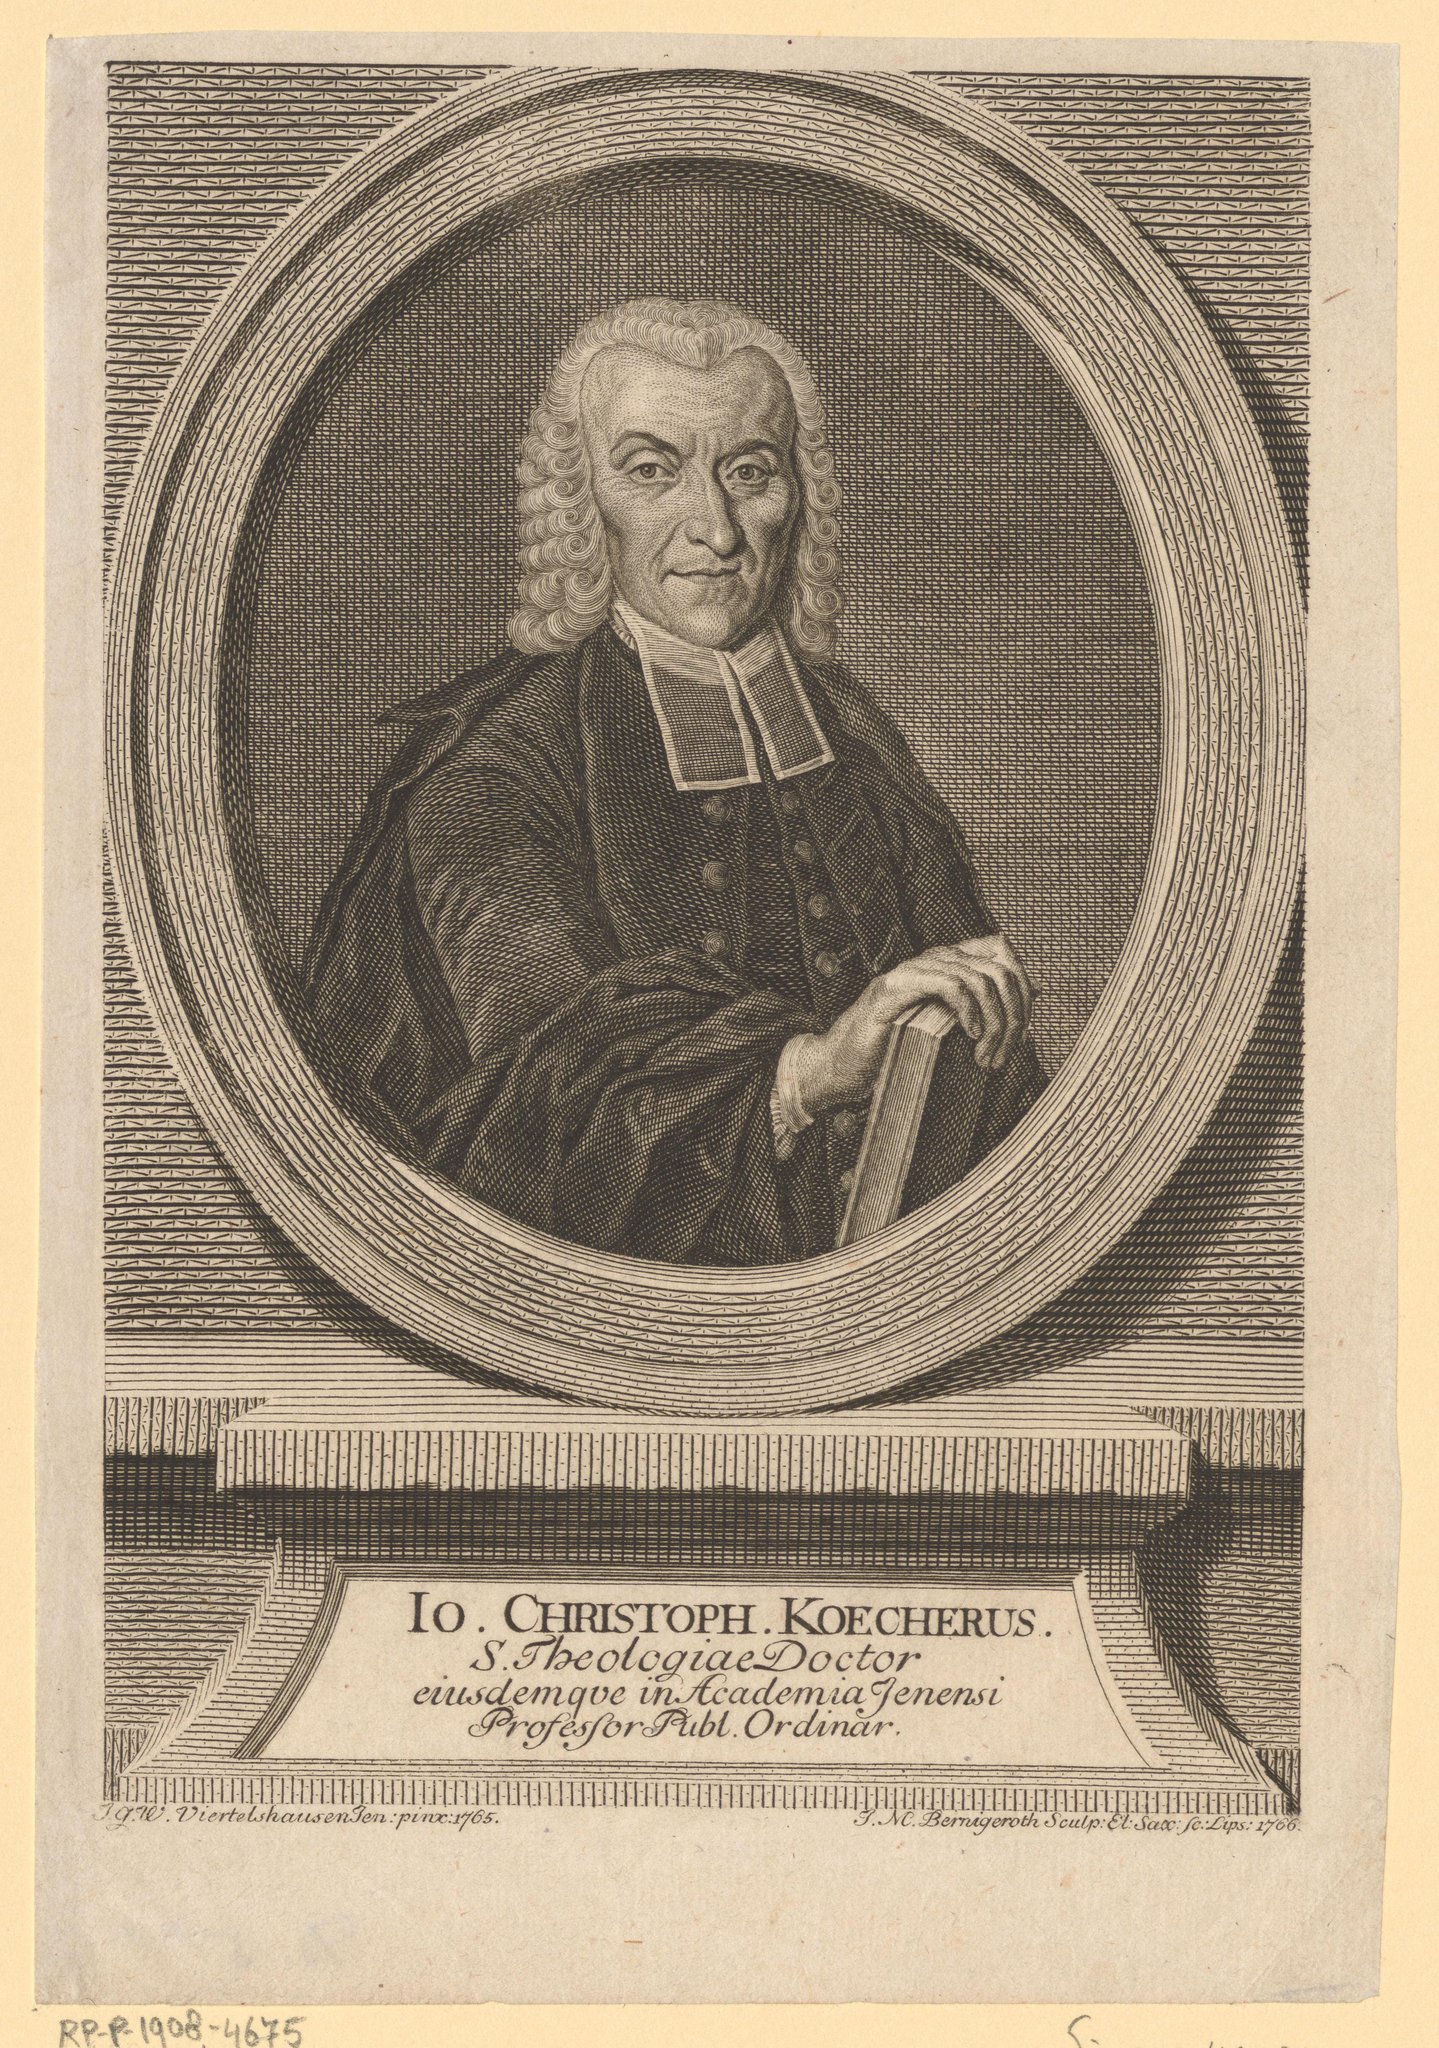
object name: print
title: Portret van Johann Christoph Köcher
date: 1766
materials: paper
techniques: engraving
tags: historical persons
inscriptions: collector's mark: Lugt 2228